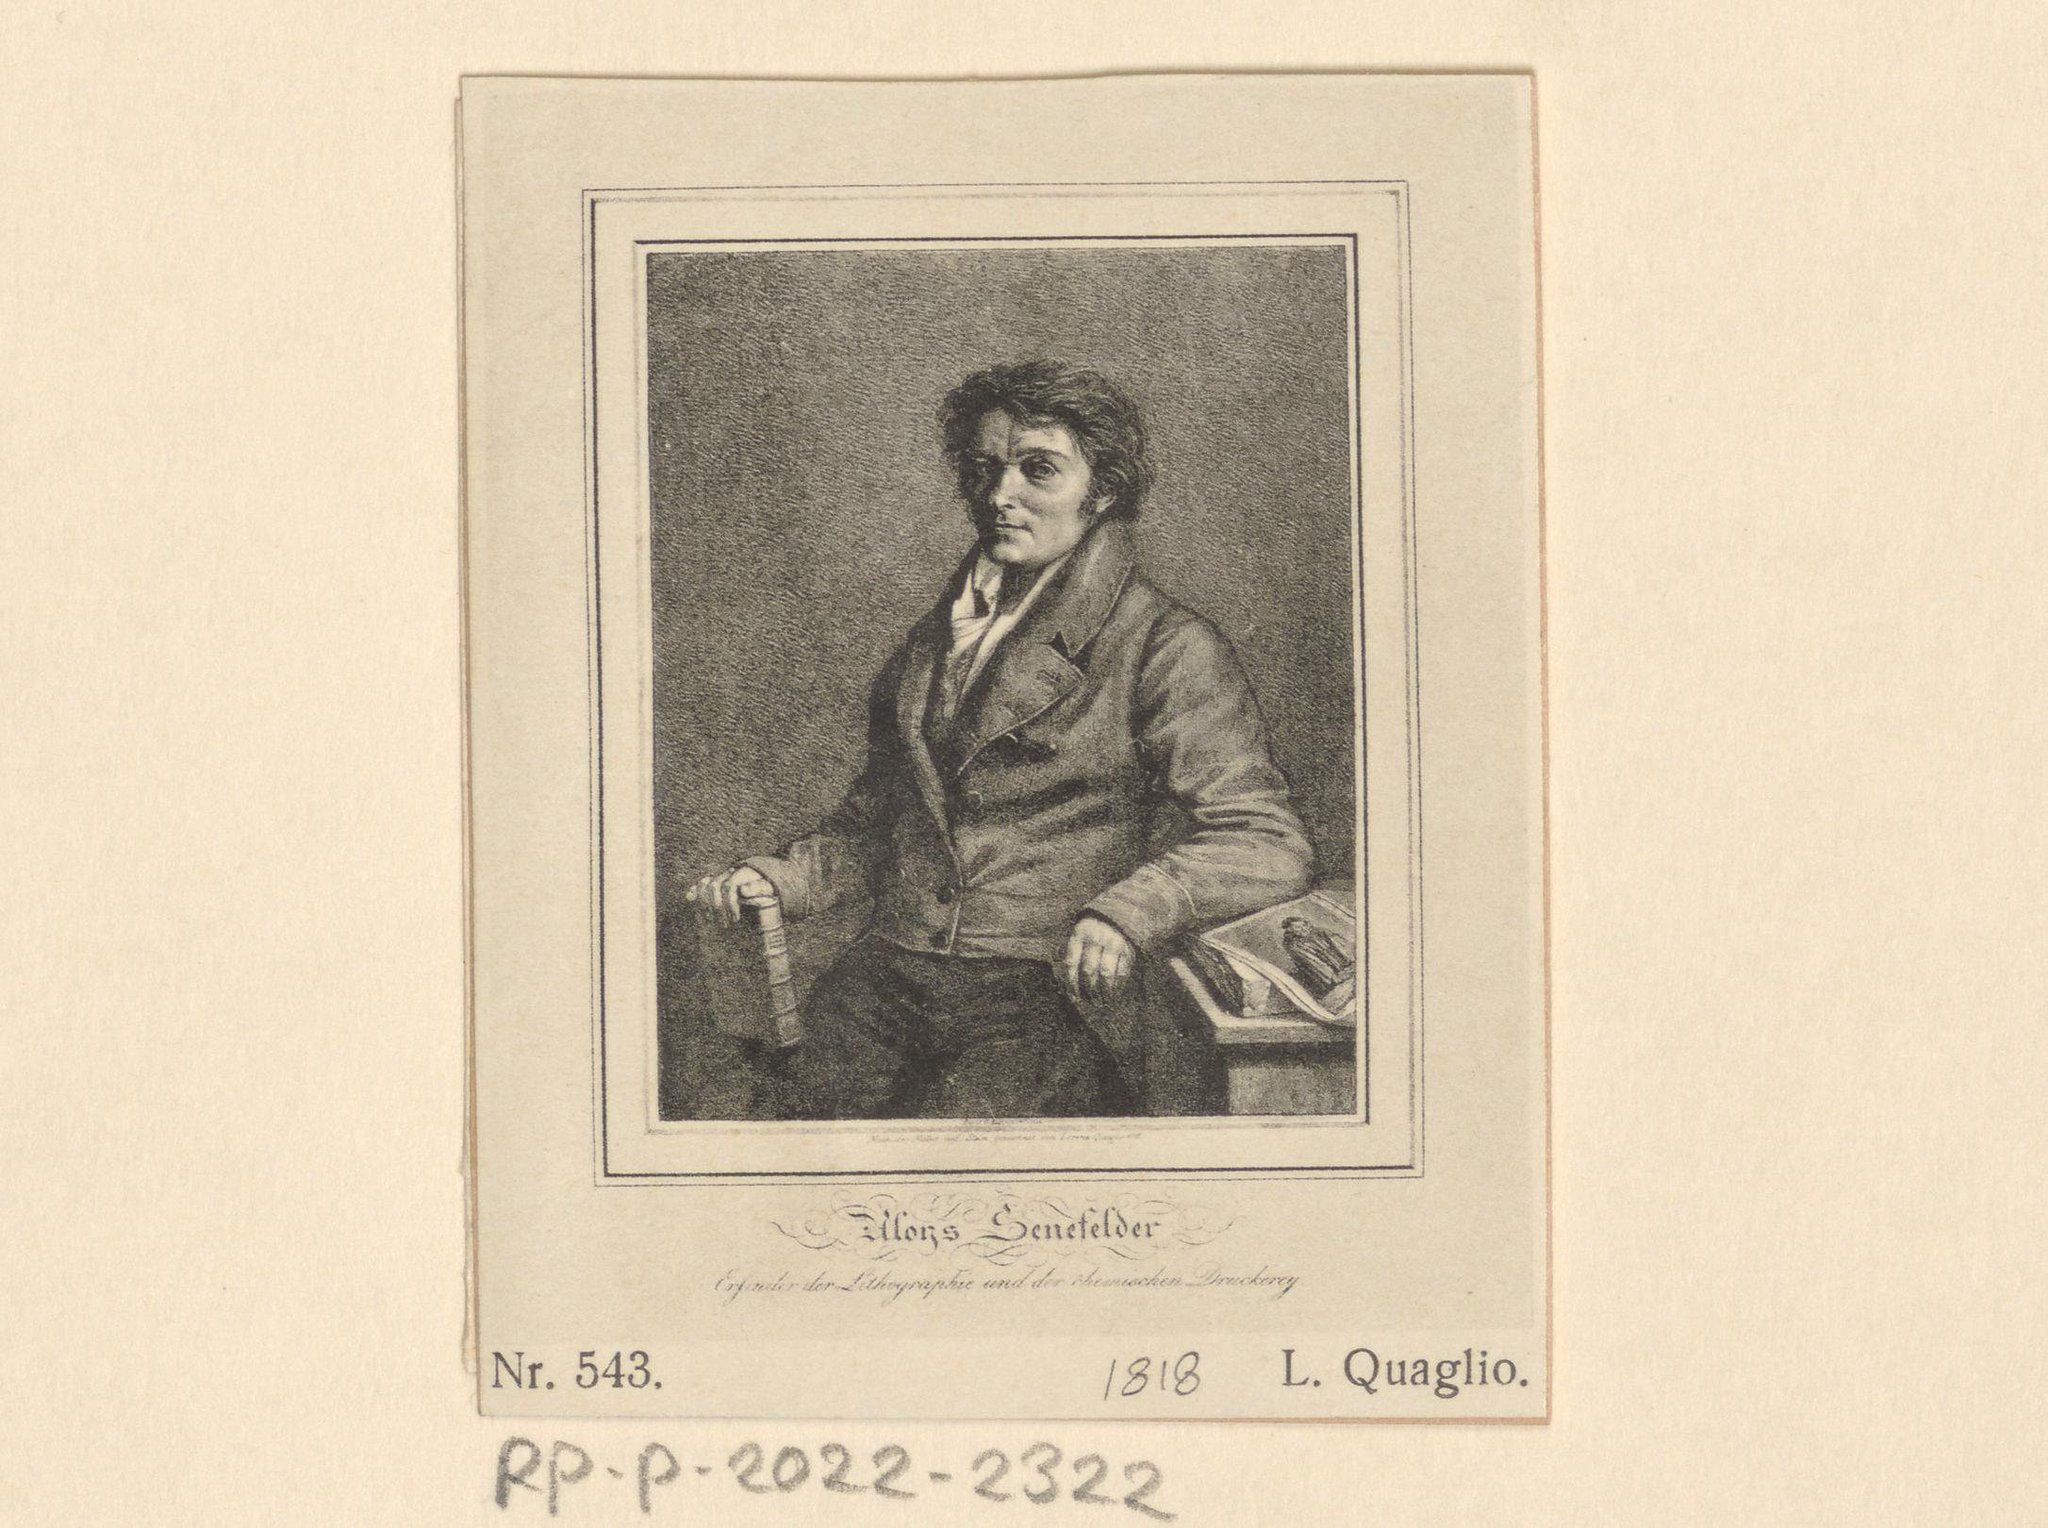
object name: photomechanical print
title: Portret van Alois Senefelder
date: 1875-1930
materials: paper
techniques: photograph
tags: prague, printer, alois senefelder, historical persons, portrait, self-portrait of graphic artist, invention, discovery ~ science and technology